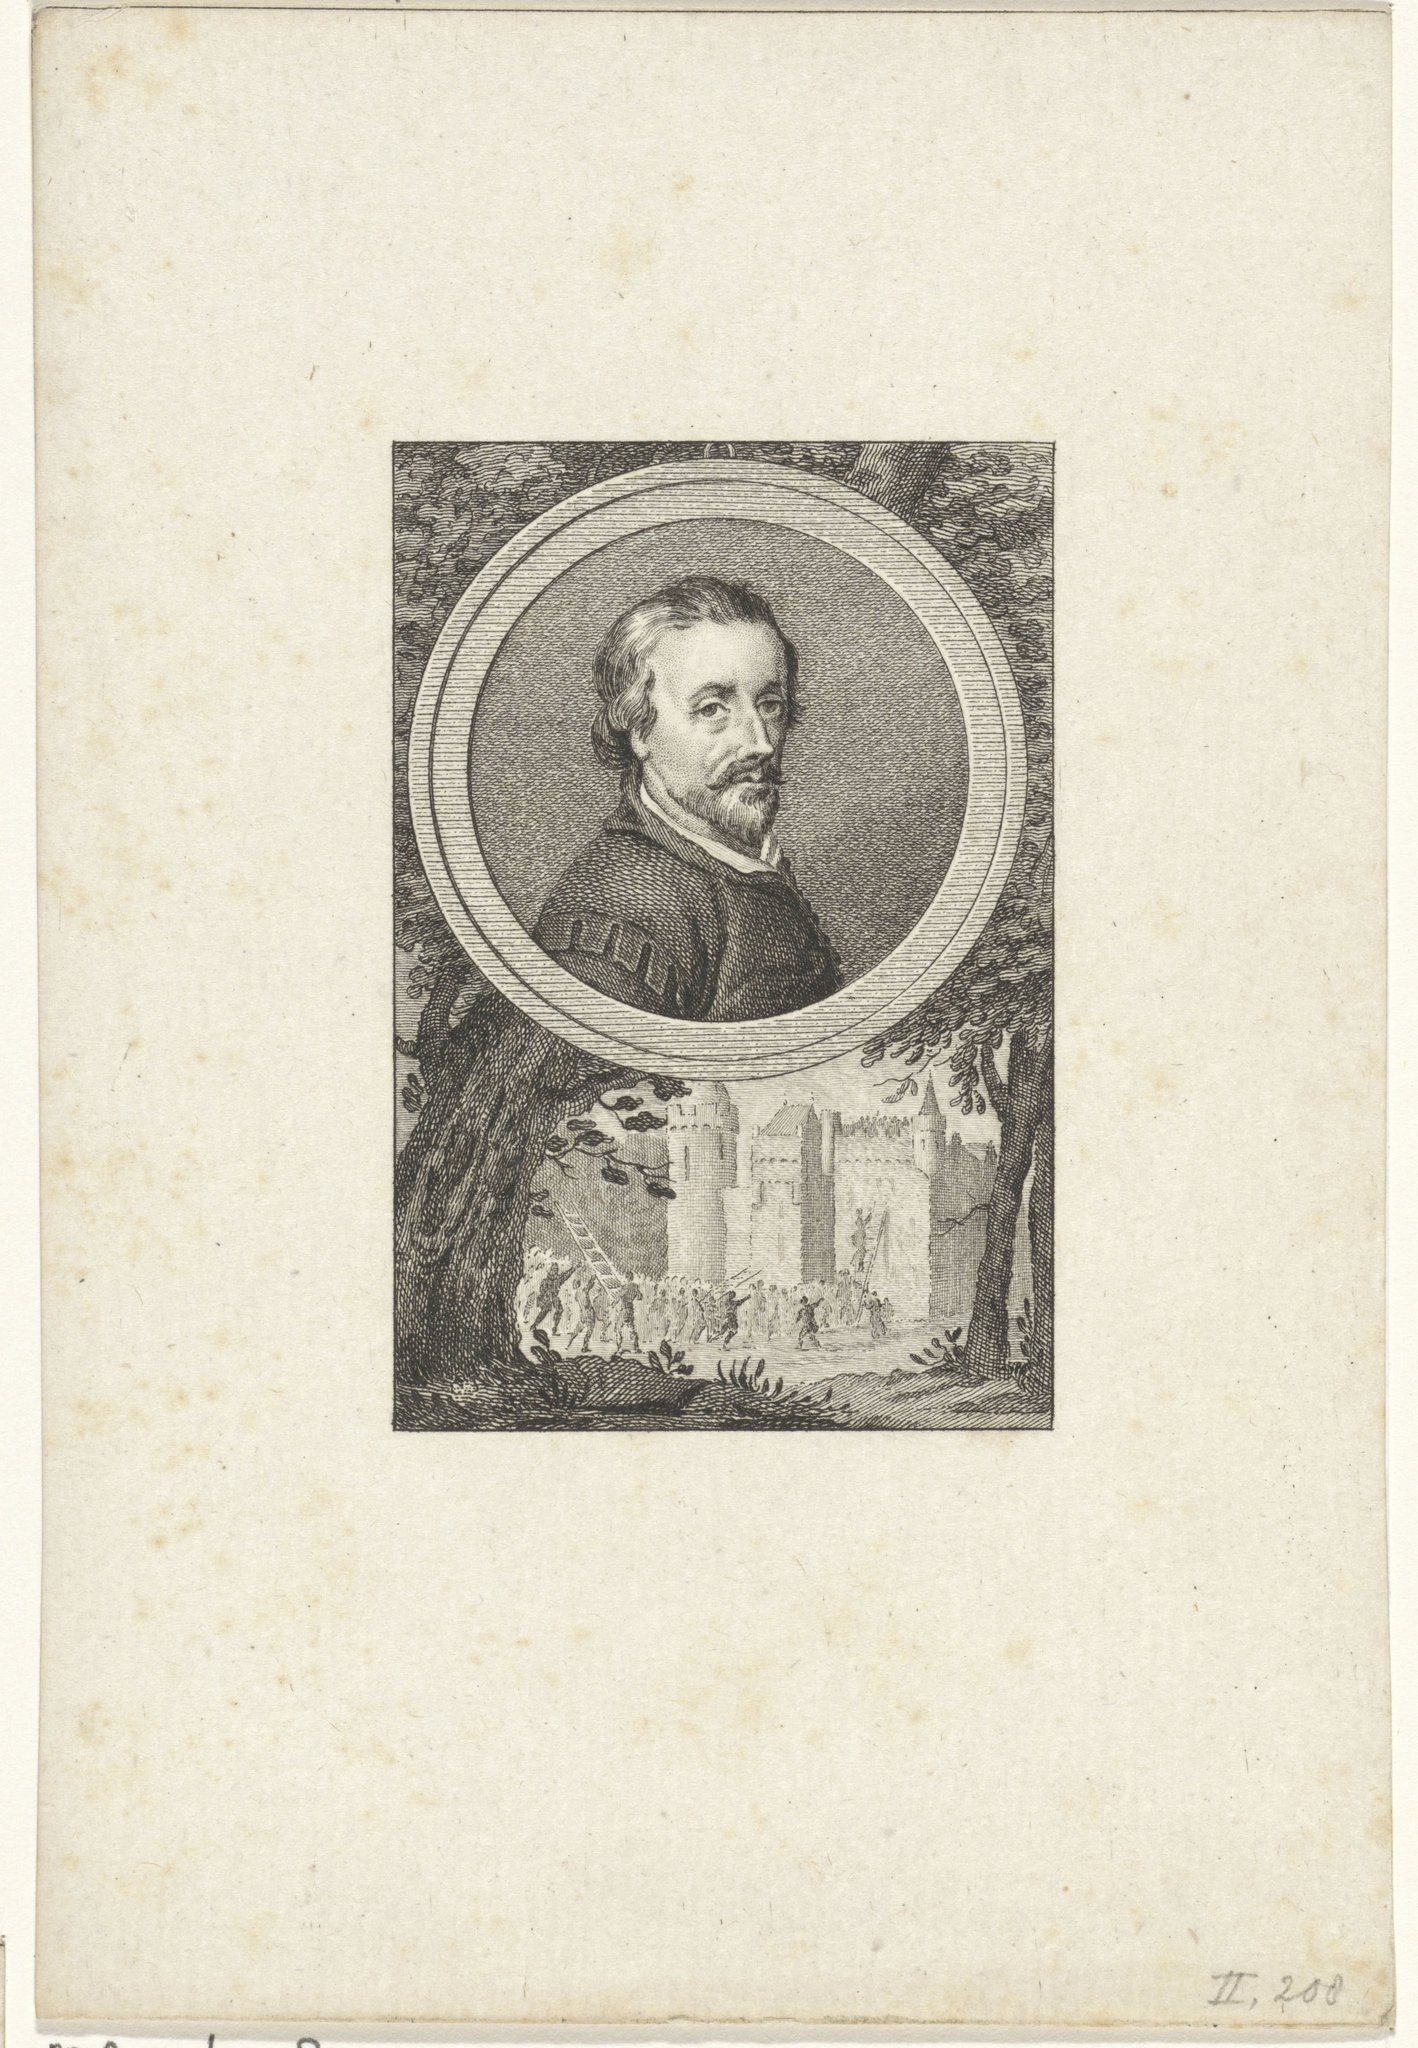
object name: print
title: Portret van Gerard van Velzen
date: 1783-1795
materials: paper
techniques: engraving, etching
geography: amsterdam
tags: breaking into city or fortress ~ siege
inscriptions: collector's mark: Lugt 2228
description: Later staat prent gebruikt in: Fokke, Jan. Geschiedenissen der Vereenigde Nederlanden voor de vaderlandsche jeugd Ie-XXVste deel. Amsterdam: Johannes Allart, 1783-1795. Deel II.